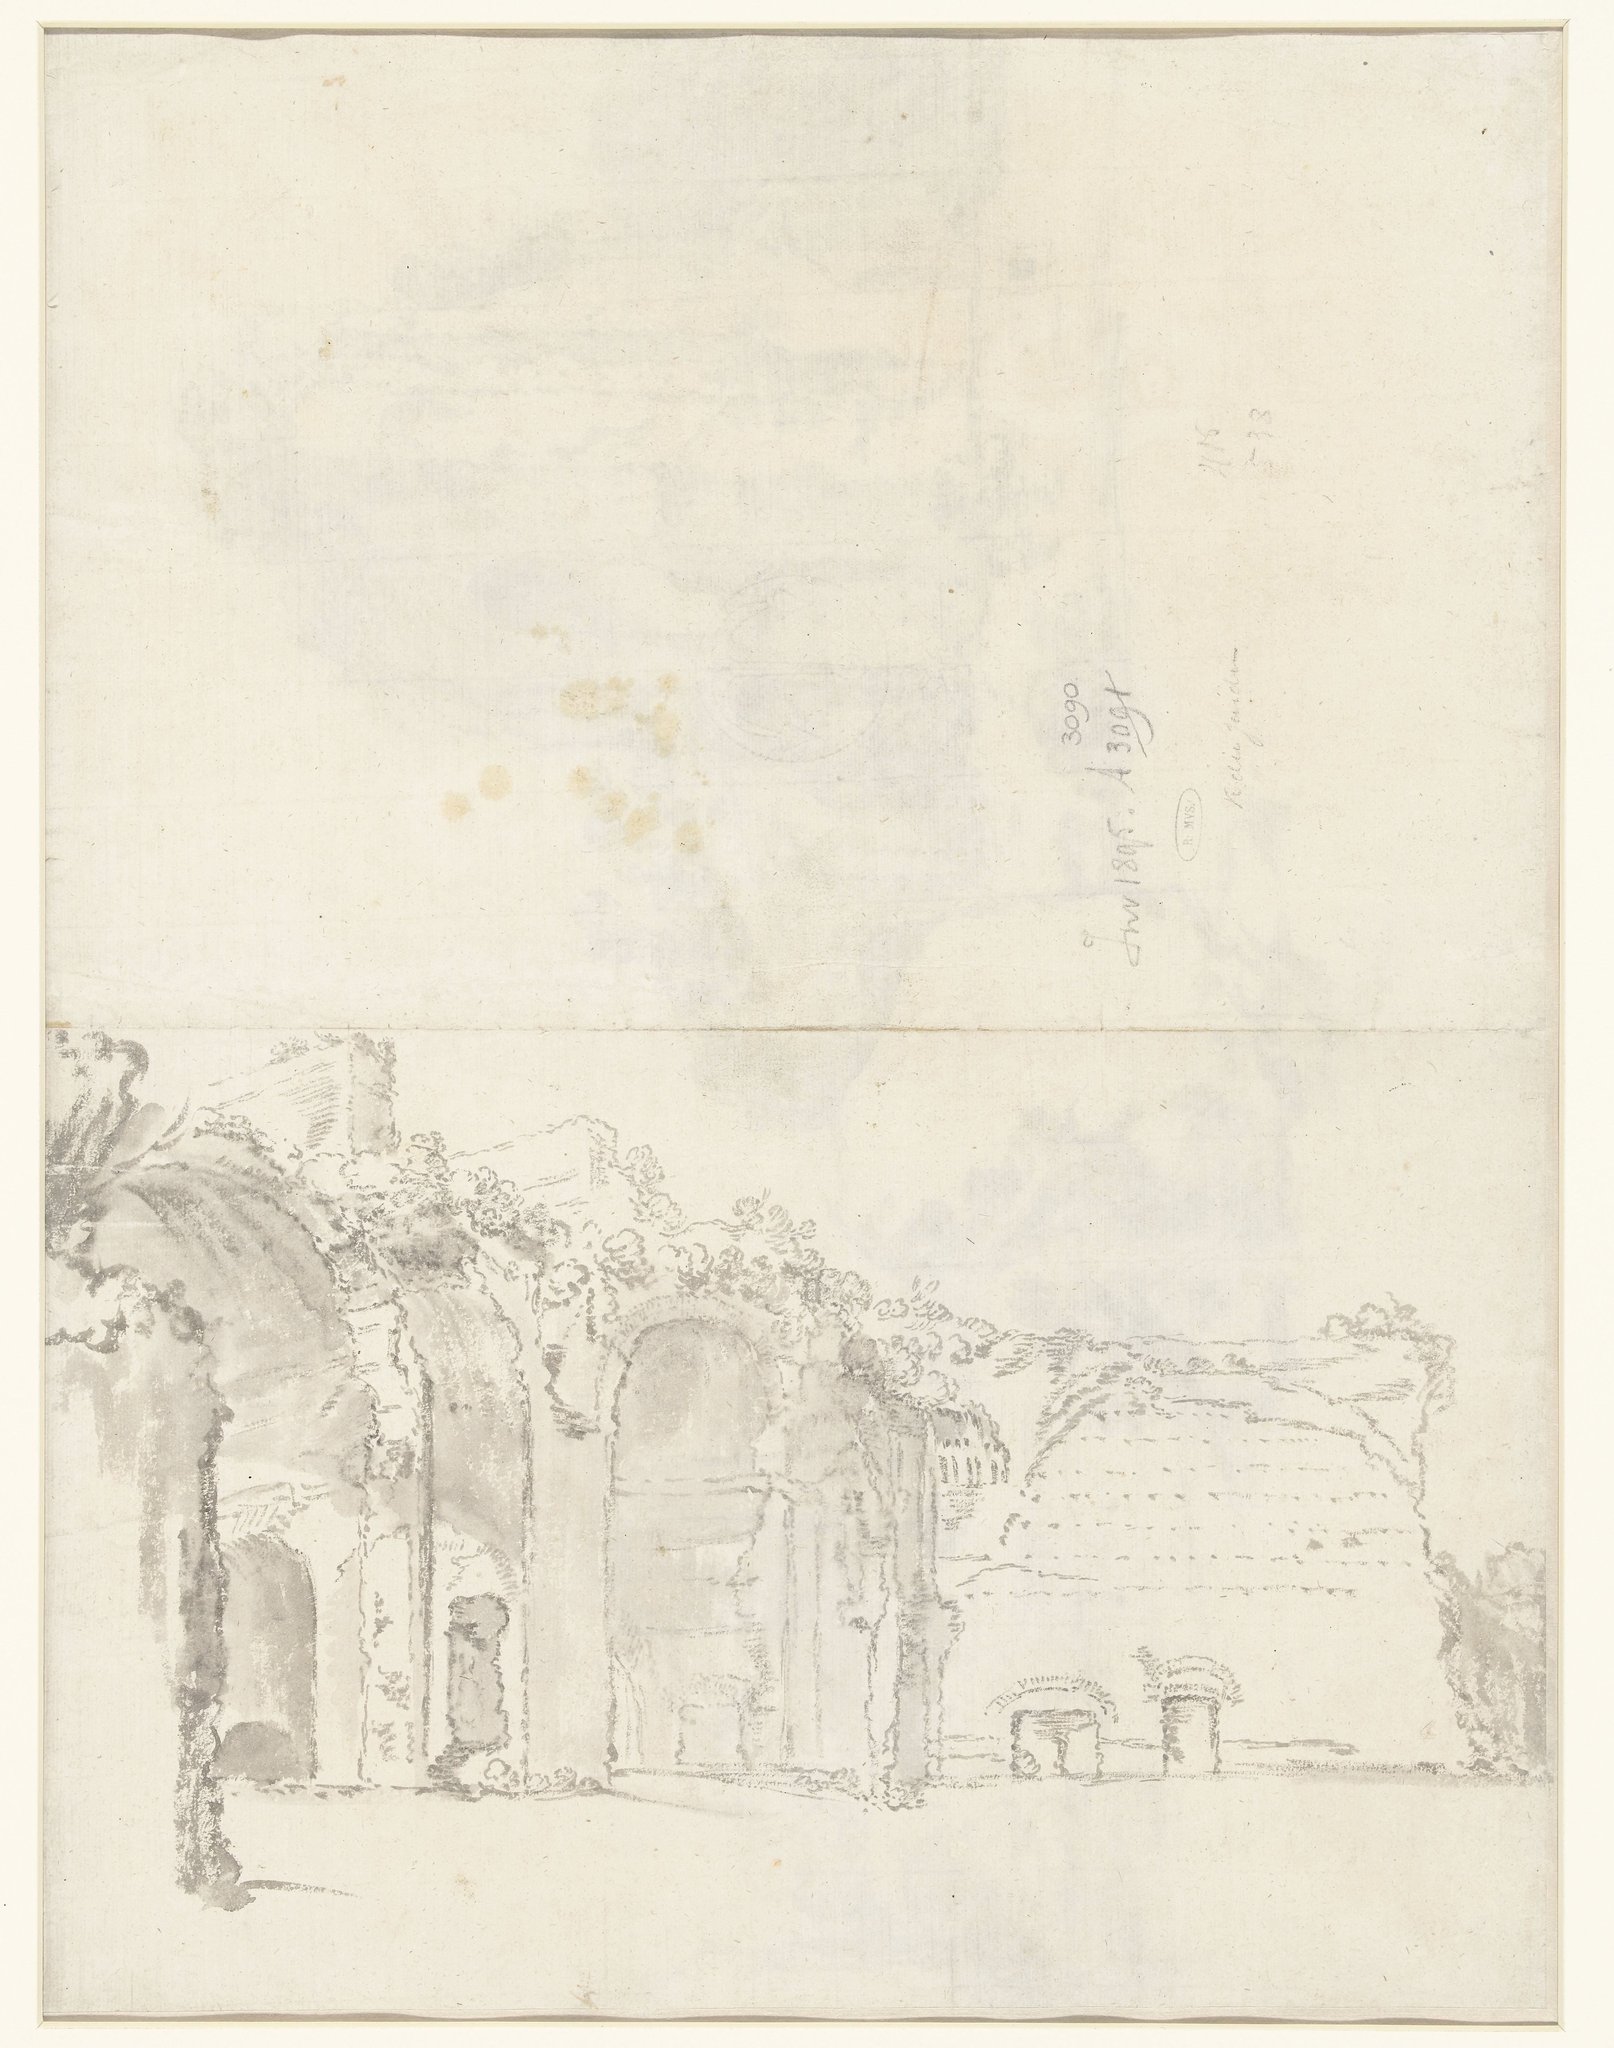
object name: drawing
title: View of Classical Ruins / recto: View of the Baths of Caracalla, Rome, with a Large Boulder in the Foreground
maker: guilliam du gardijn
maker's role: draughtsman, painter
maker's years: 1595-1657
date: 1620-1625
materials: paper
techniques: brush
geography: rome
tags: ruin of a building ~ architecture, italy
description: Schets van een ruïne (op de onderste helft van het blad).